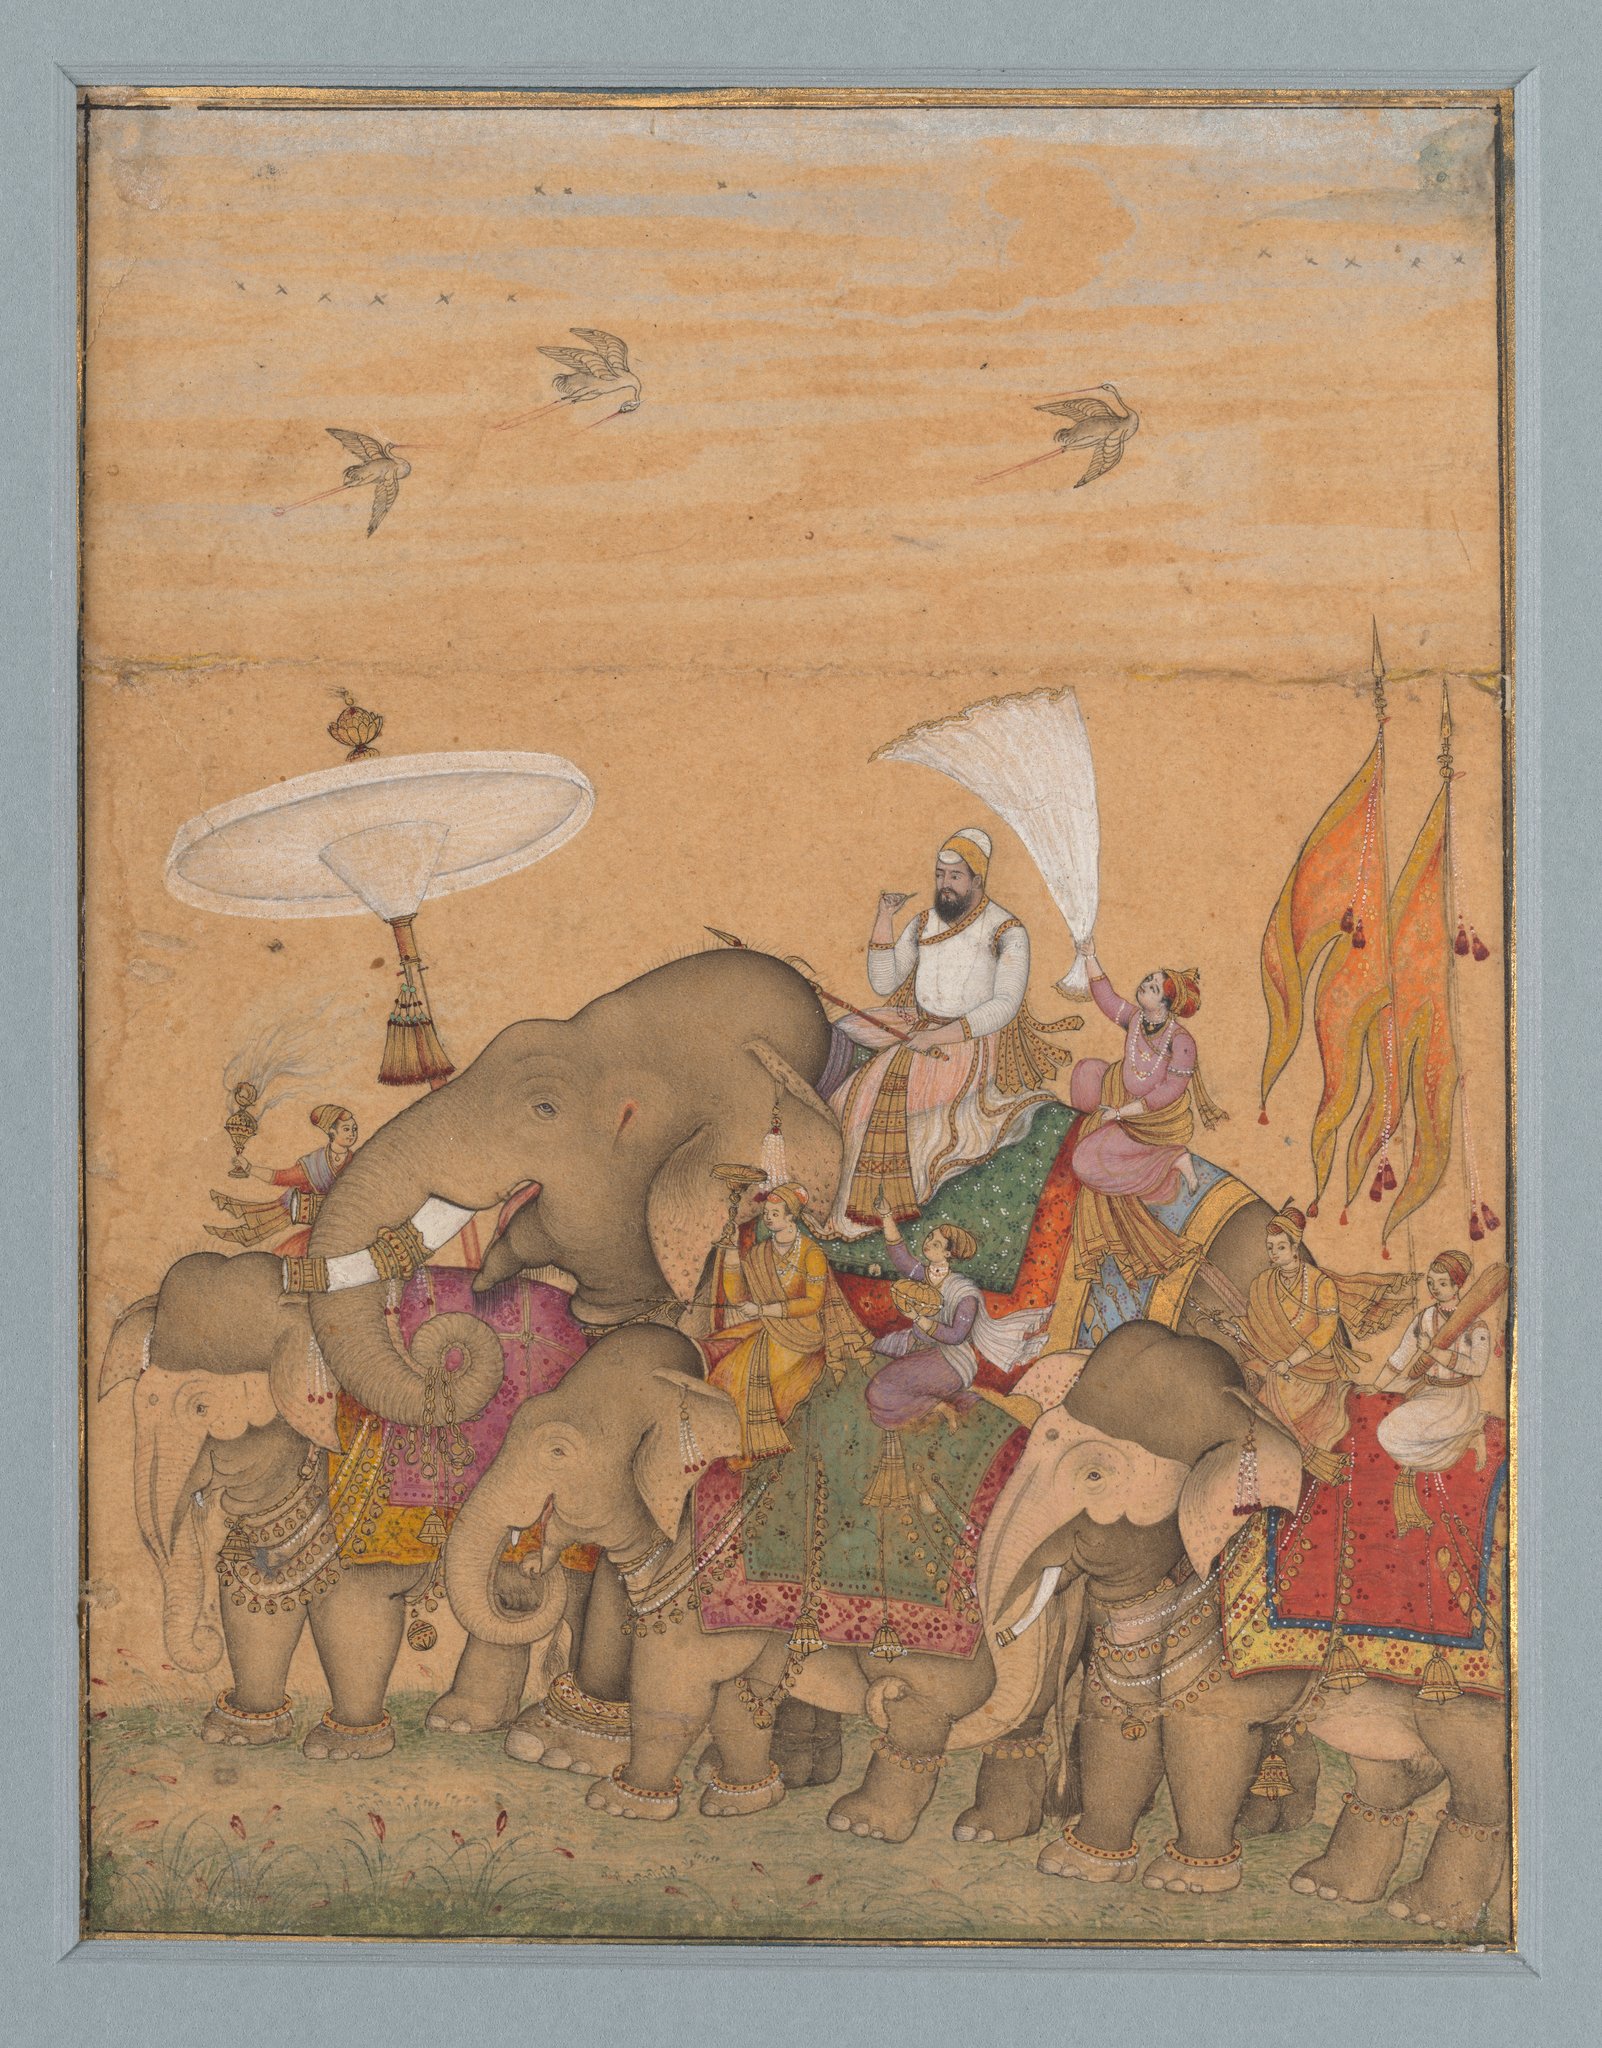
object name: illustrated album leaf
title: Sultan Ibrahim 'Adil Shah II in Procession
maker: 'ali riza 'abbasi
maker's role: artist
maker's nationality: indian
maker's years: 1575-1675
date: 1634-1666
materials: gold, paper, watercolor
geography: india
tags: elephants